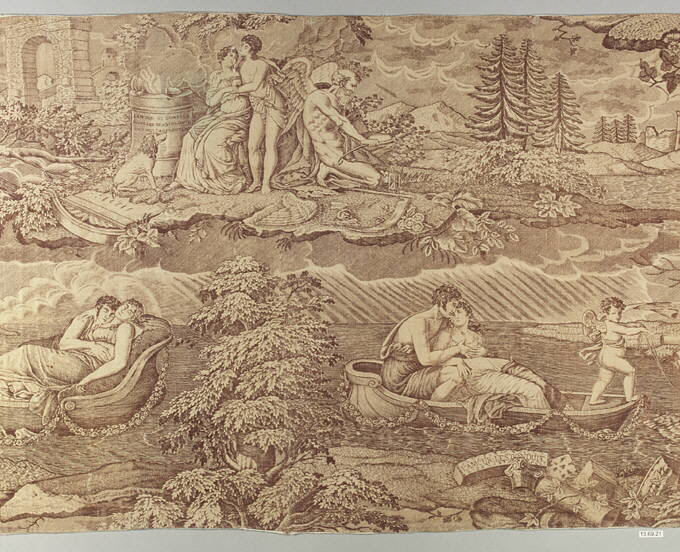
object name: furnishing textile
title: Pictorial print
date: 1815-1825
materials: cotton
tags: couples,men,women,dogs,boats